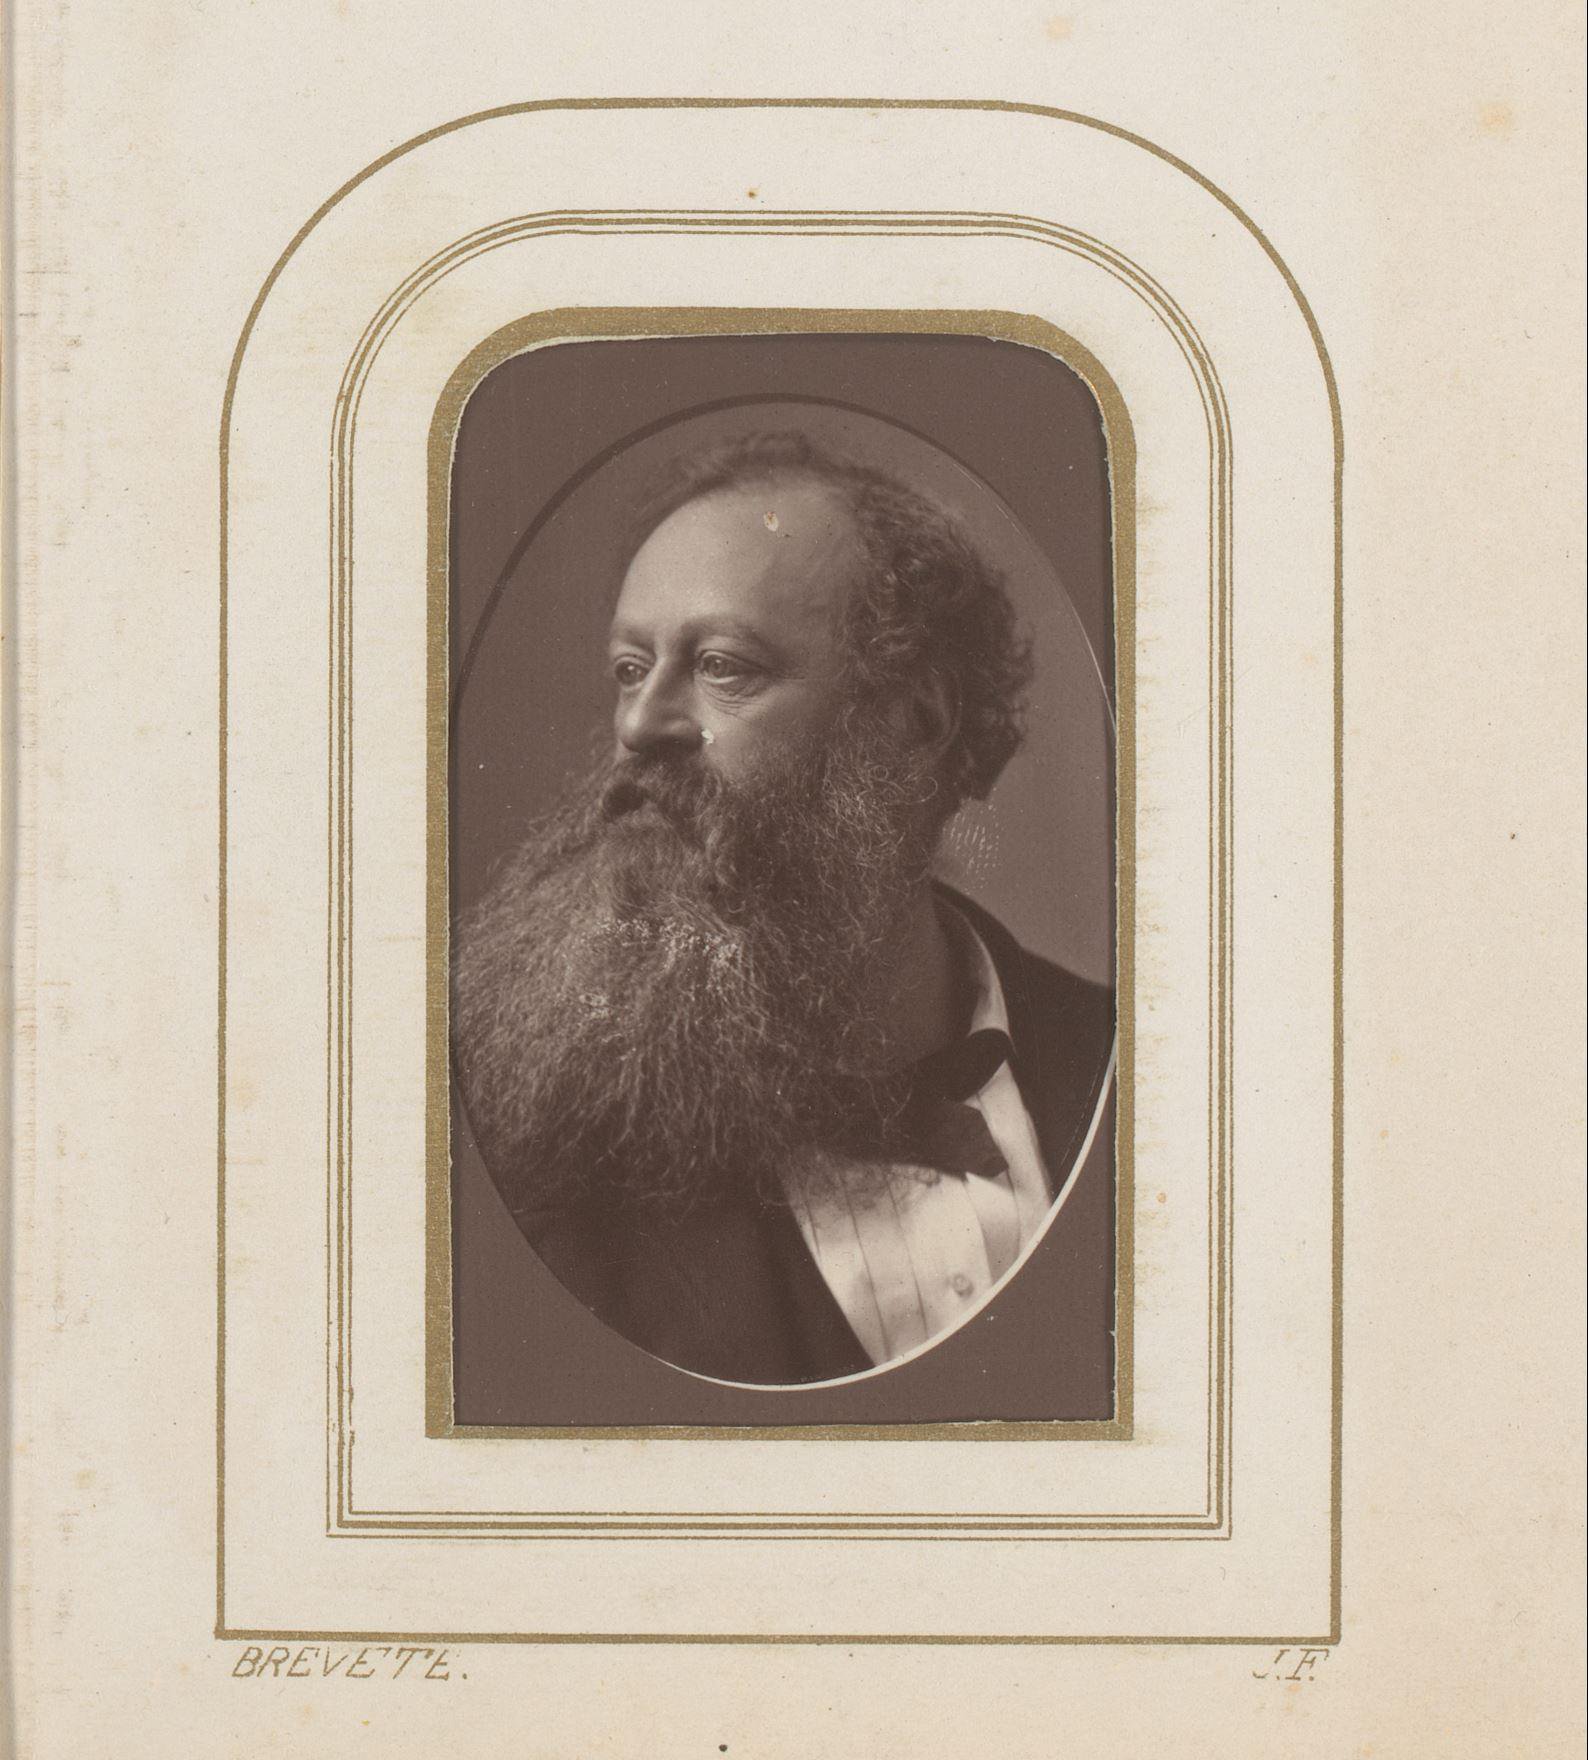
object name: album leaf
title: Portret van een man met baard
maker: Anonymous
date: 1870-1890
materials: cardboard, photographic support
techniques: albumen print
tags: historical persons, beard